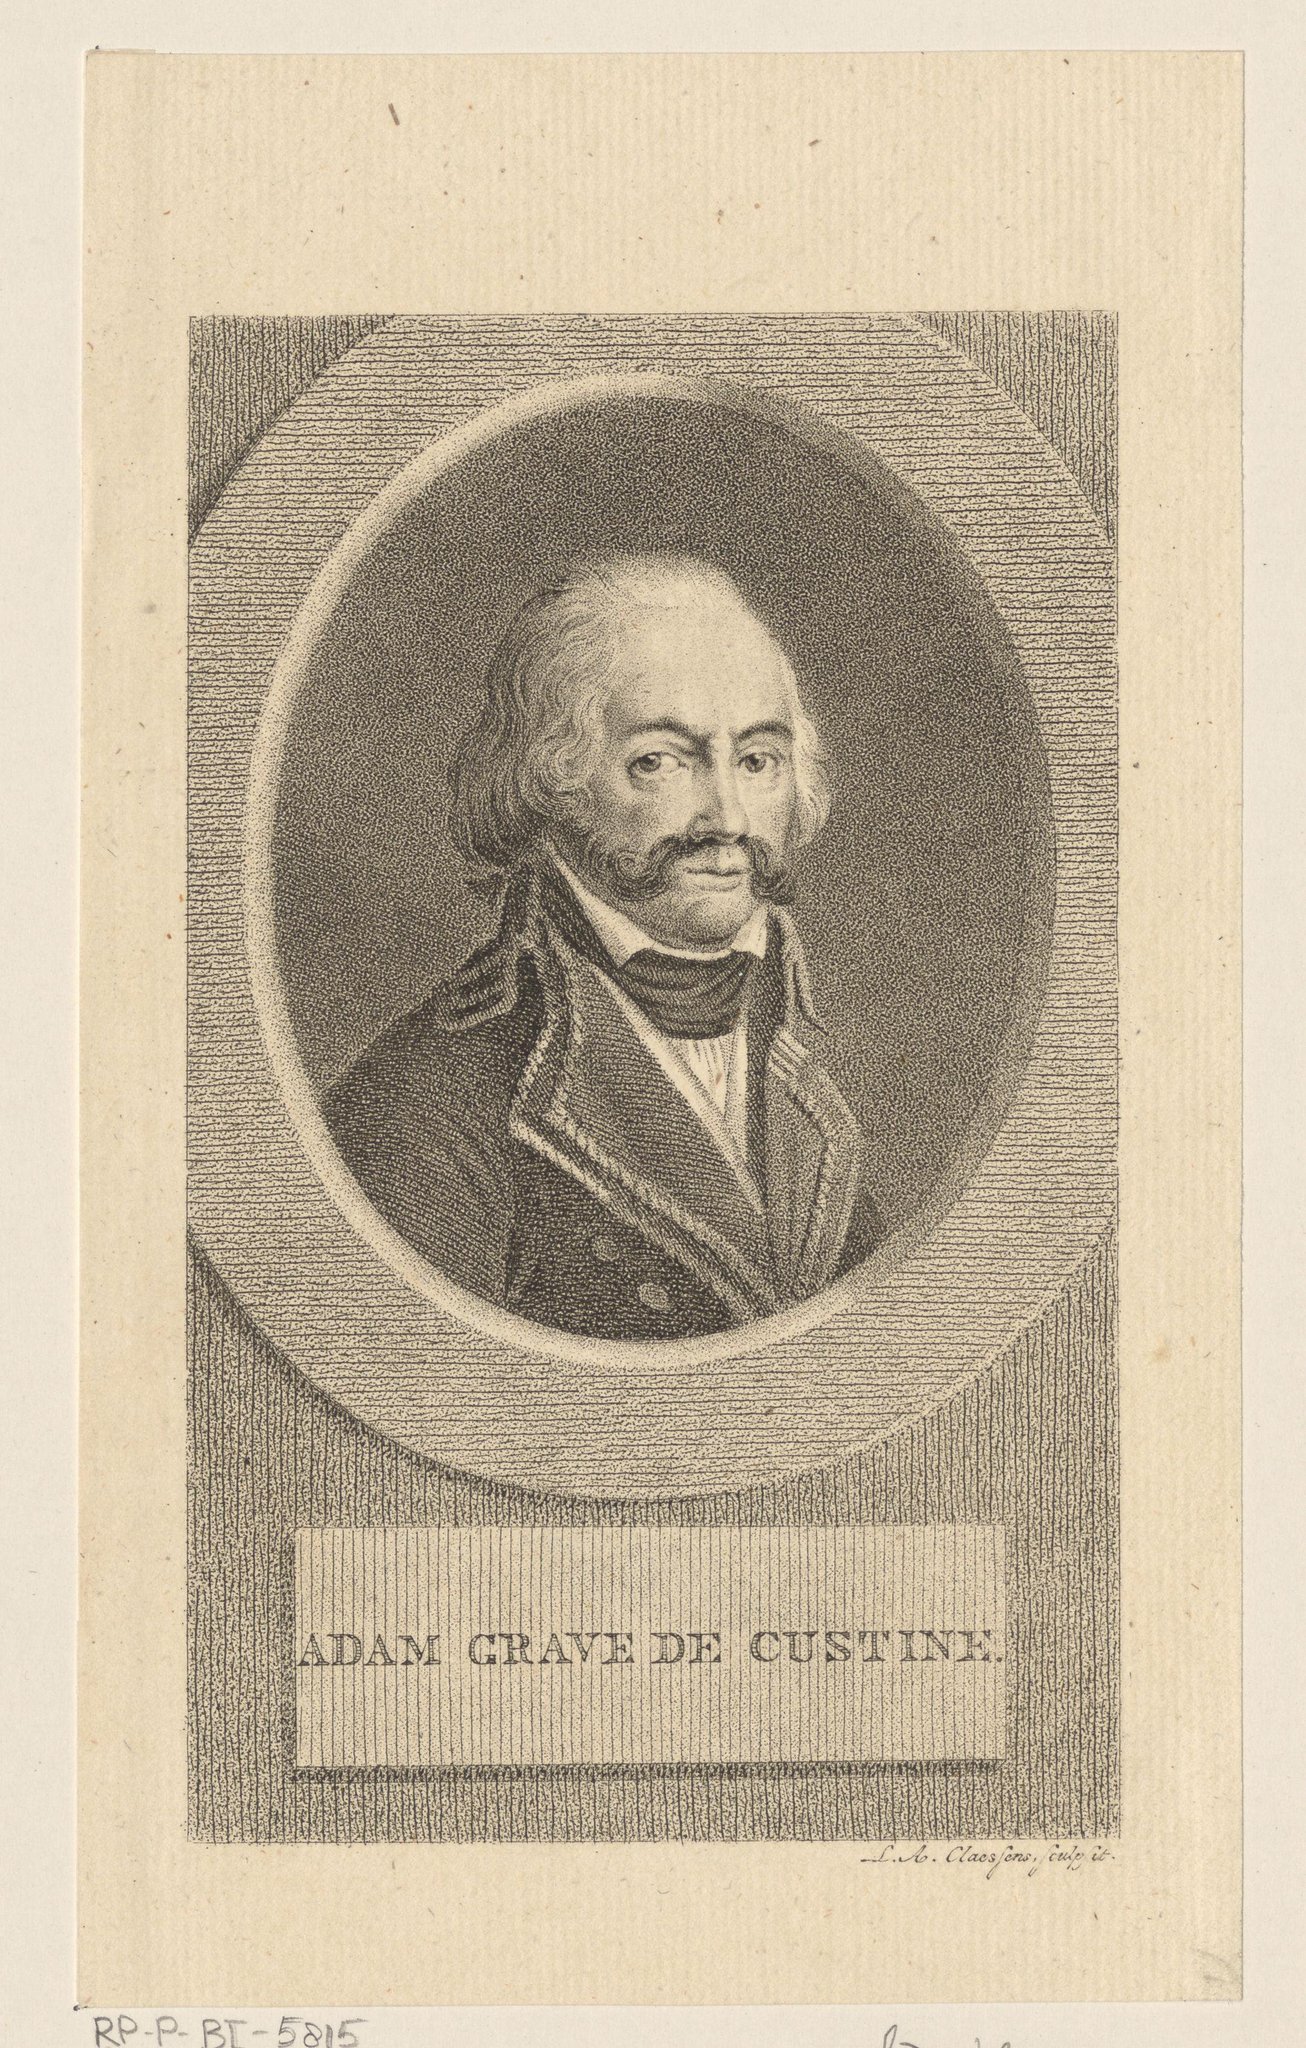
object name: print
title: Portret van graaf Adam-Philippe de Custine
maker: lambertus antonius claessens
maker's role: draughtsman, print maker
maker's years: 1763-1834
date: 1801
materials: paper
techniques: engraving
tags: paris, historical persons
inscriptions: collector's mark: Lugt 2228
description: Prent mogelijk uit: Tafereelen van de staatsomwenteling in Frankrijk. Amsterdam: Johannes Allart, 1801, dl. 13.